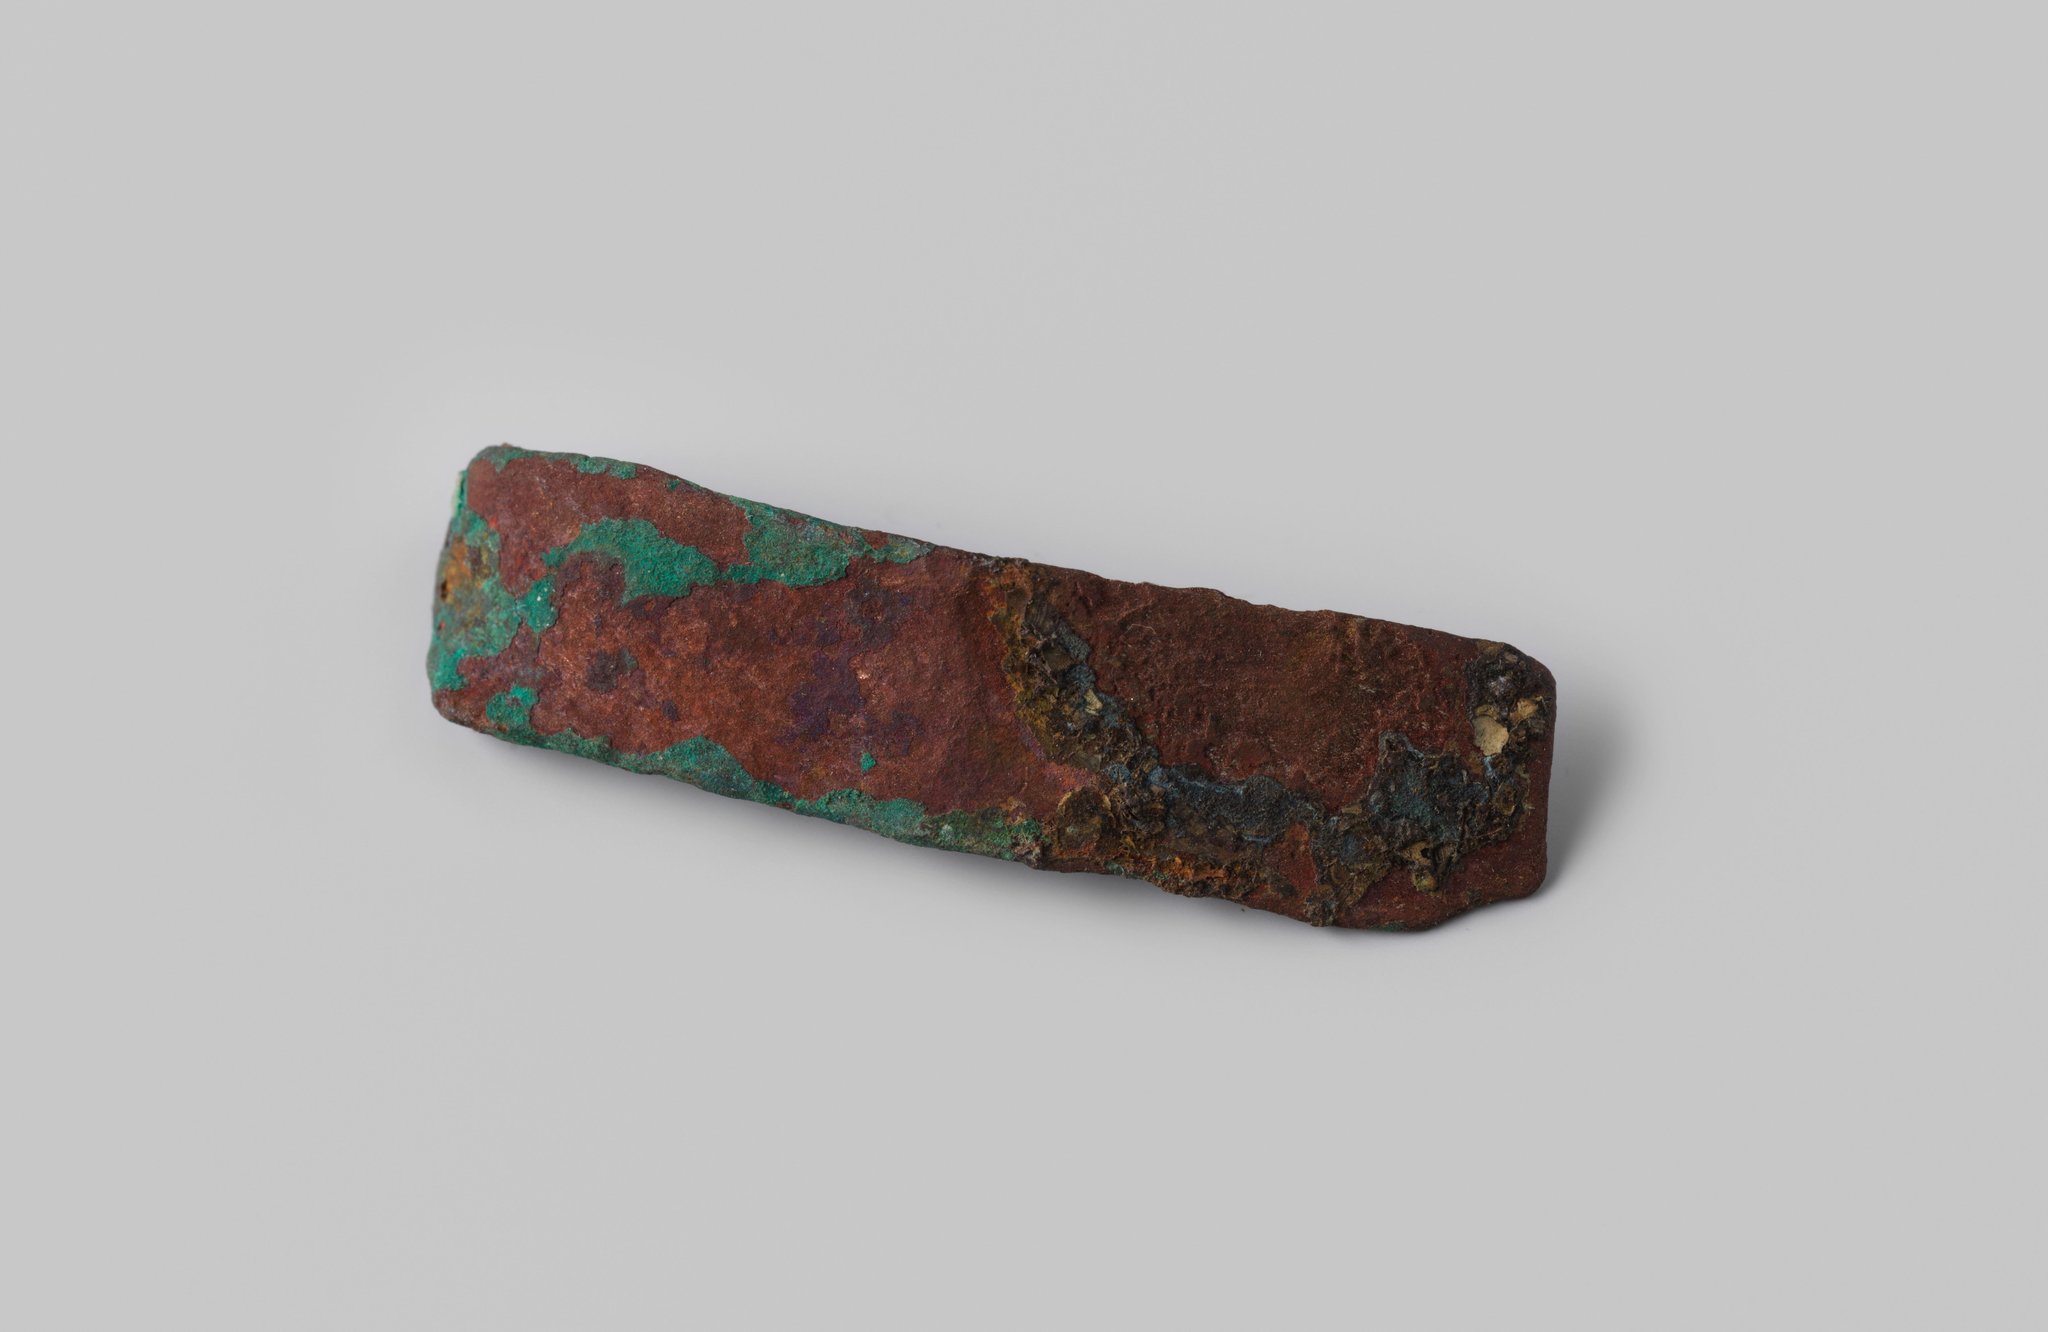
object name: fragment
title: Fragment van koper uit het wrak van de Oost-Indiëvaarder Hollandia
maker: Anonymous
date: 1700-1743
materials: copper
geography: netherlands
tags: verenigde oostindische compagnie, hollandia (schip), annet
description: Varied parts or fragments, strips and strip-shaped fragments; fragm.